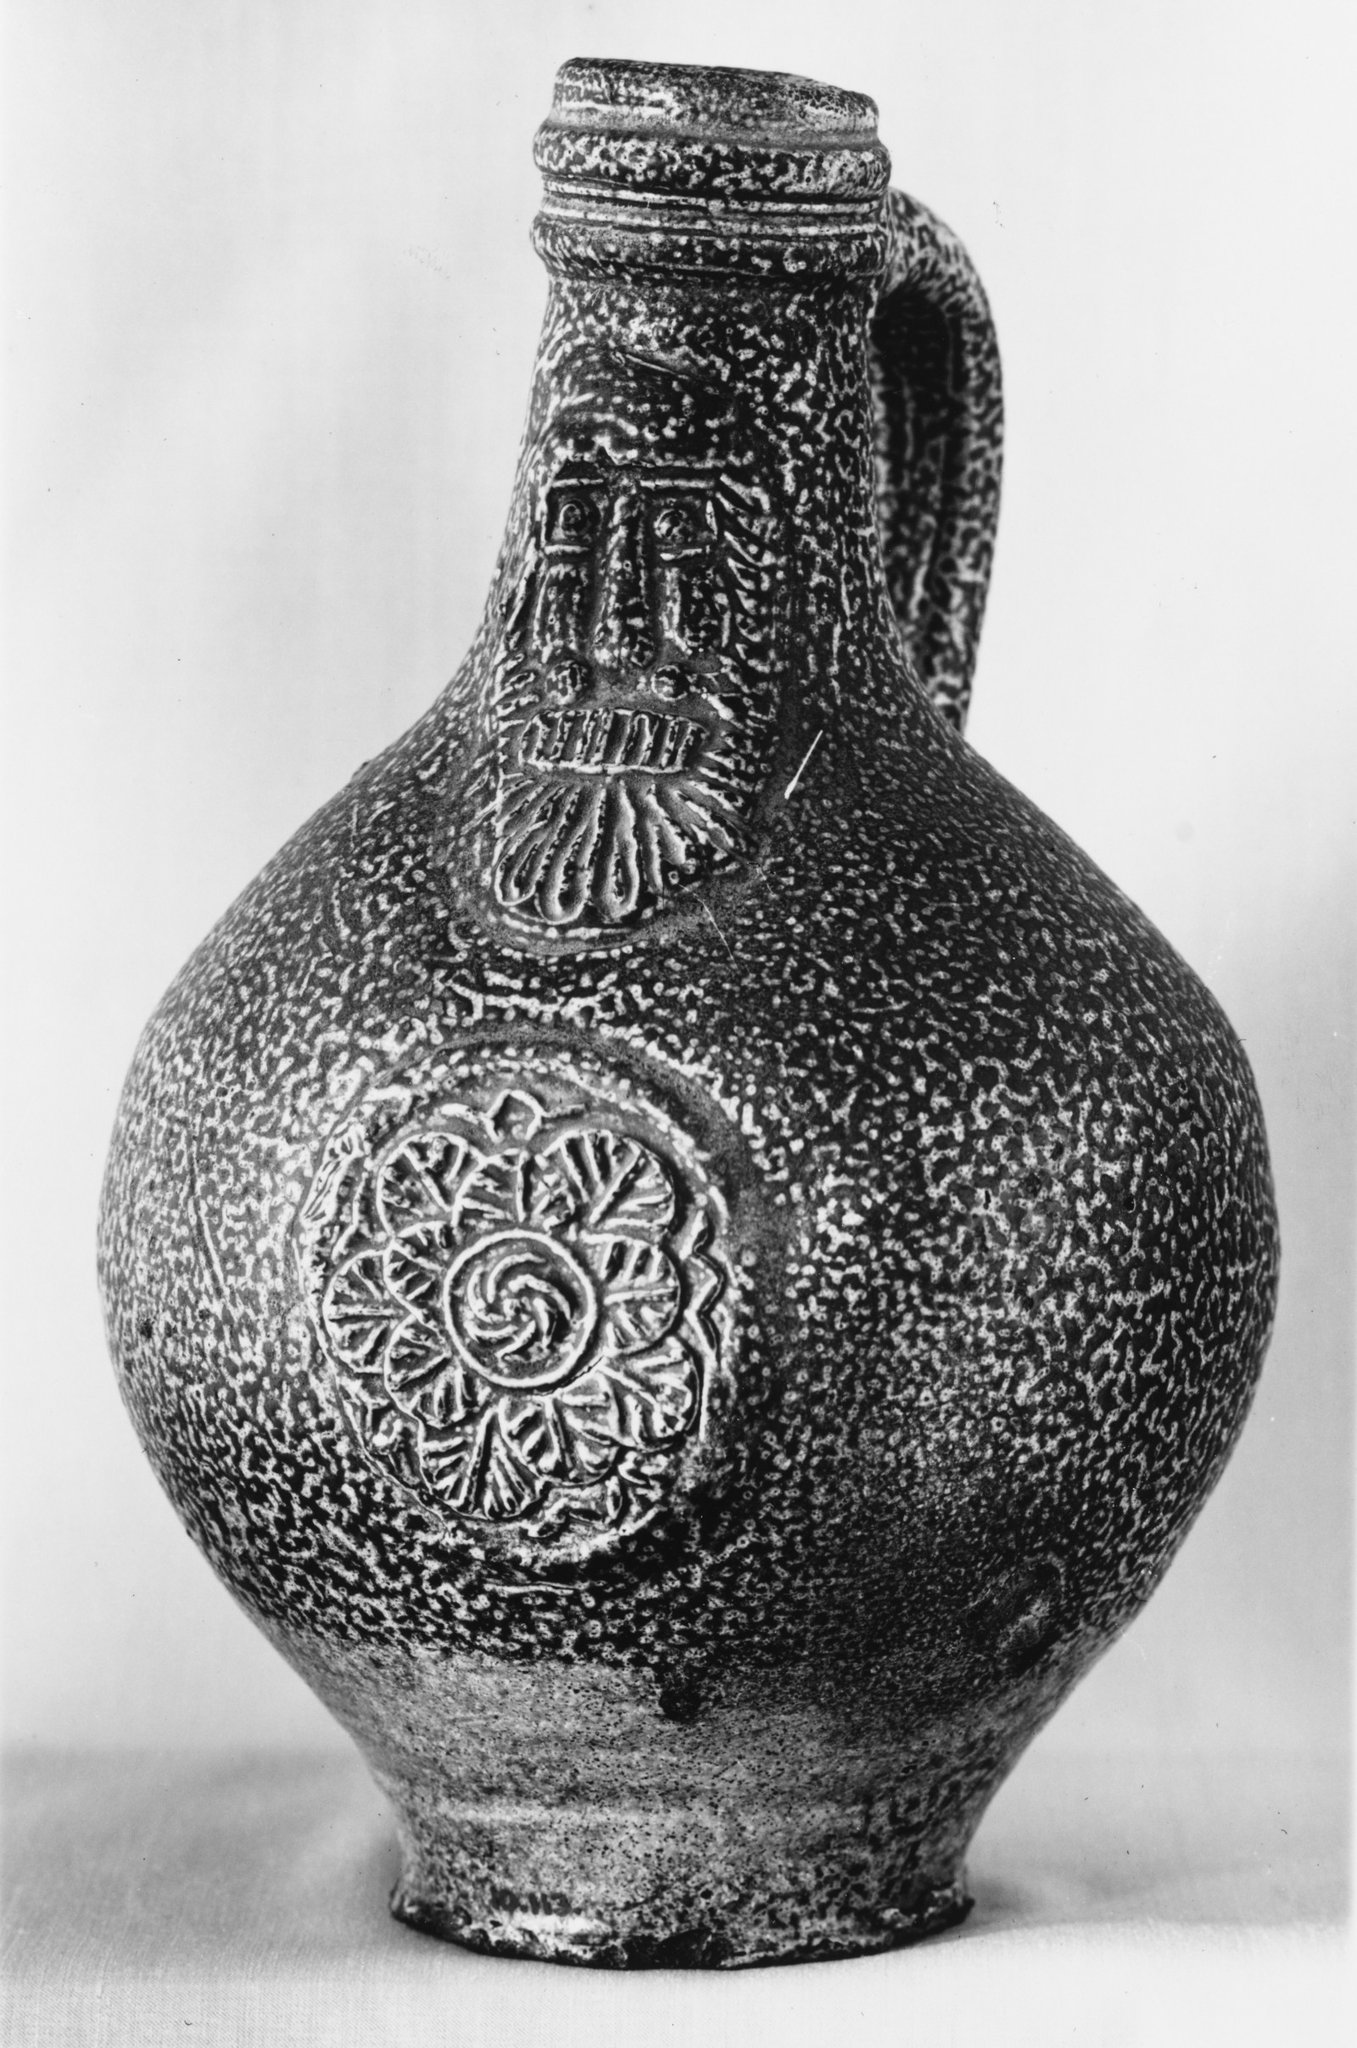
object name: bellarmine jug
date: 1660-1680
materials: stoneware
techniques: salt glaze